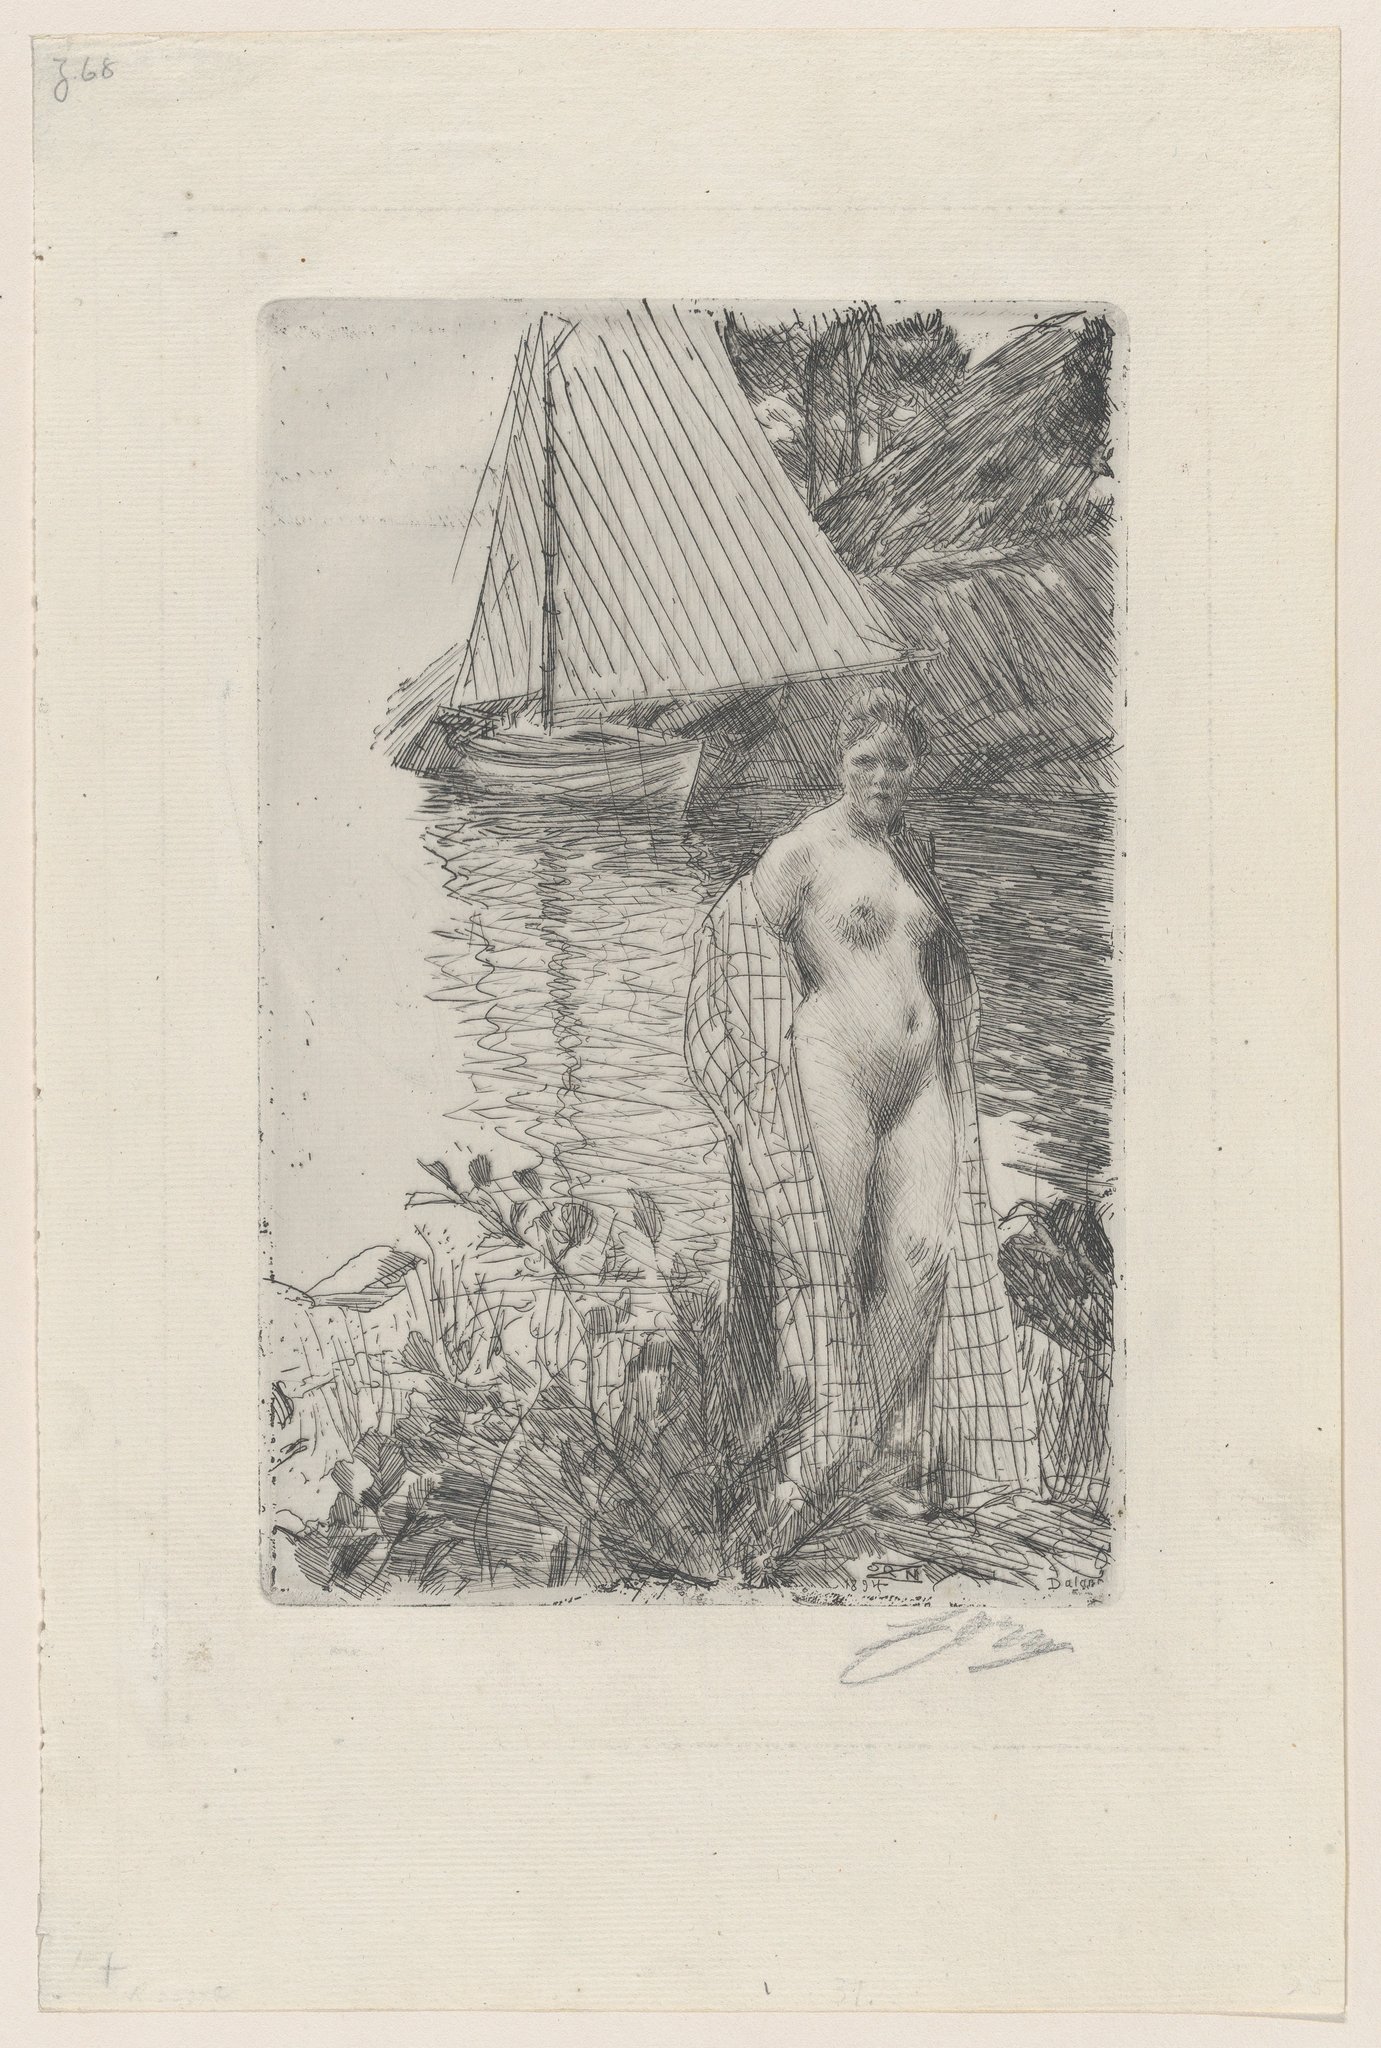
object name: print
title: My Model and My Boat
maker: anders zorn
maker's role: artist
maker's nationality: swedish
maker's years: 1860-1920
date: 1894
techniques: drypoint, etching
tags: female nudes,boats